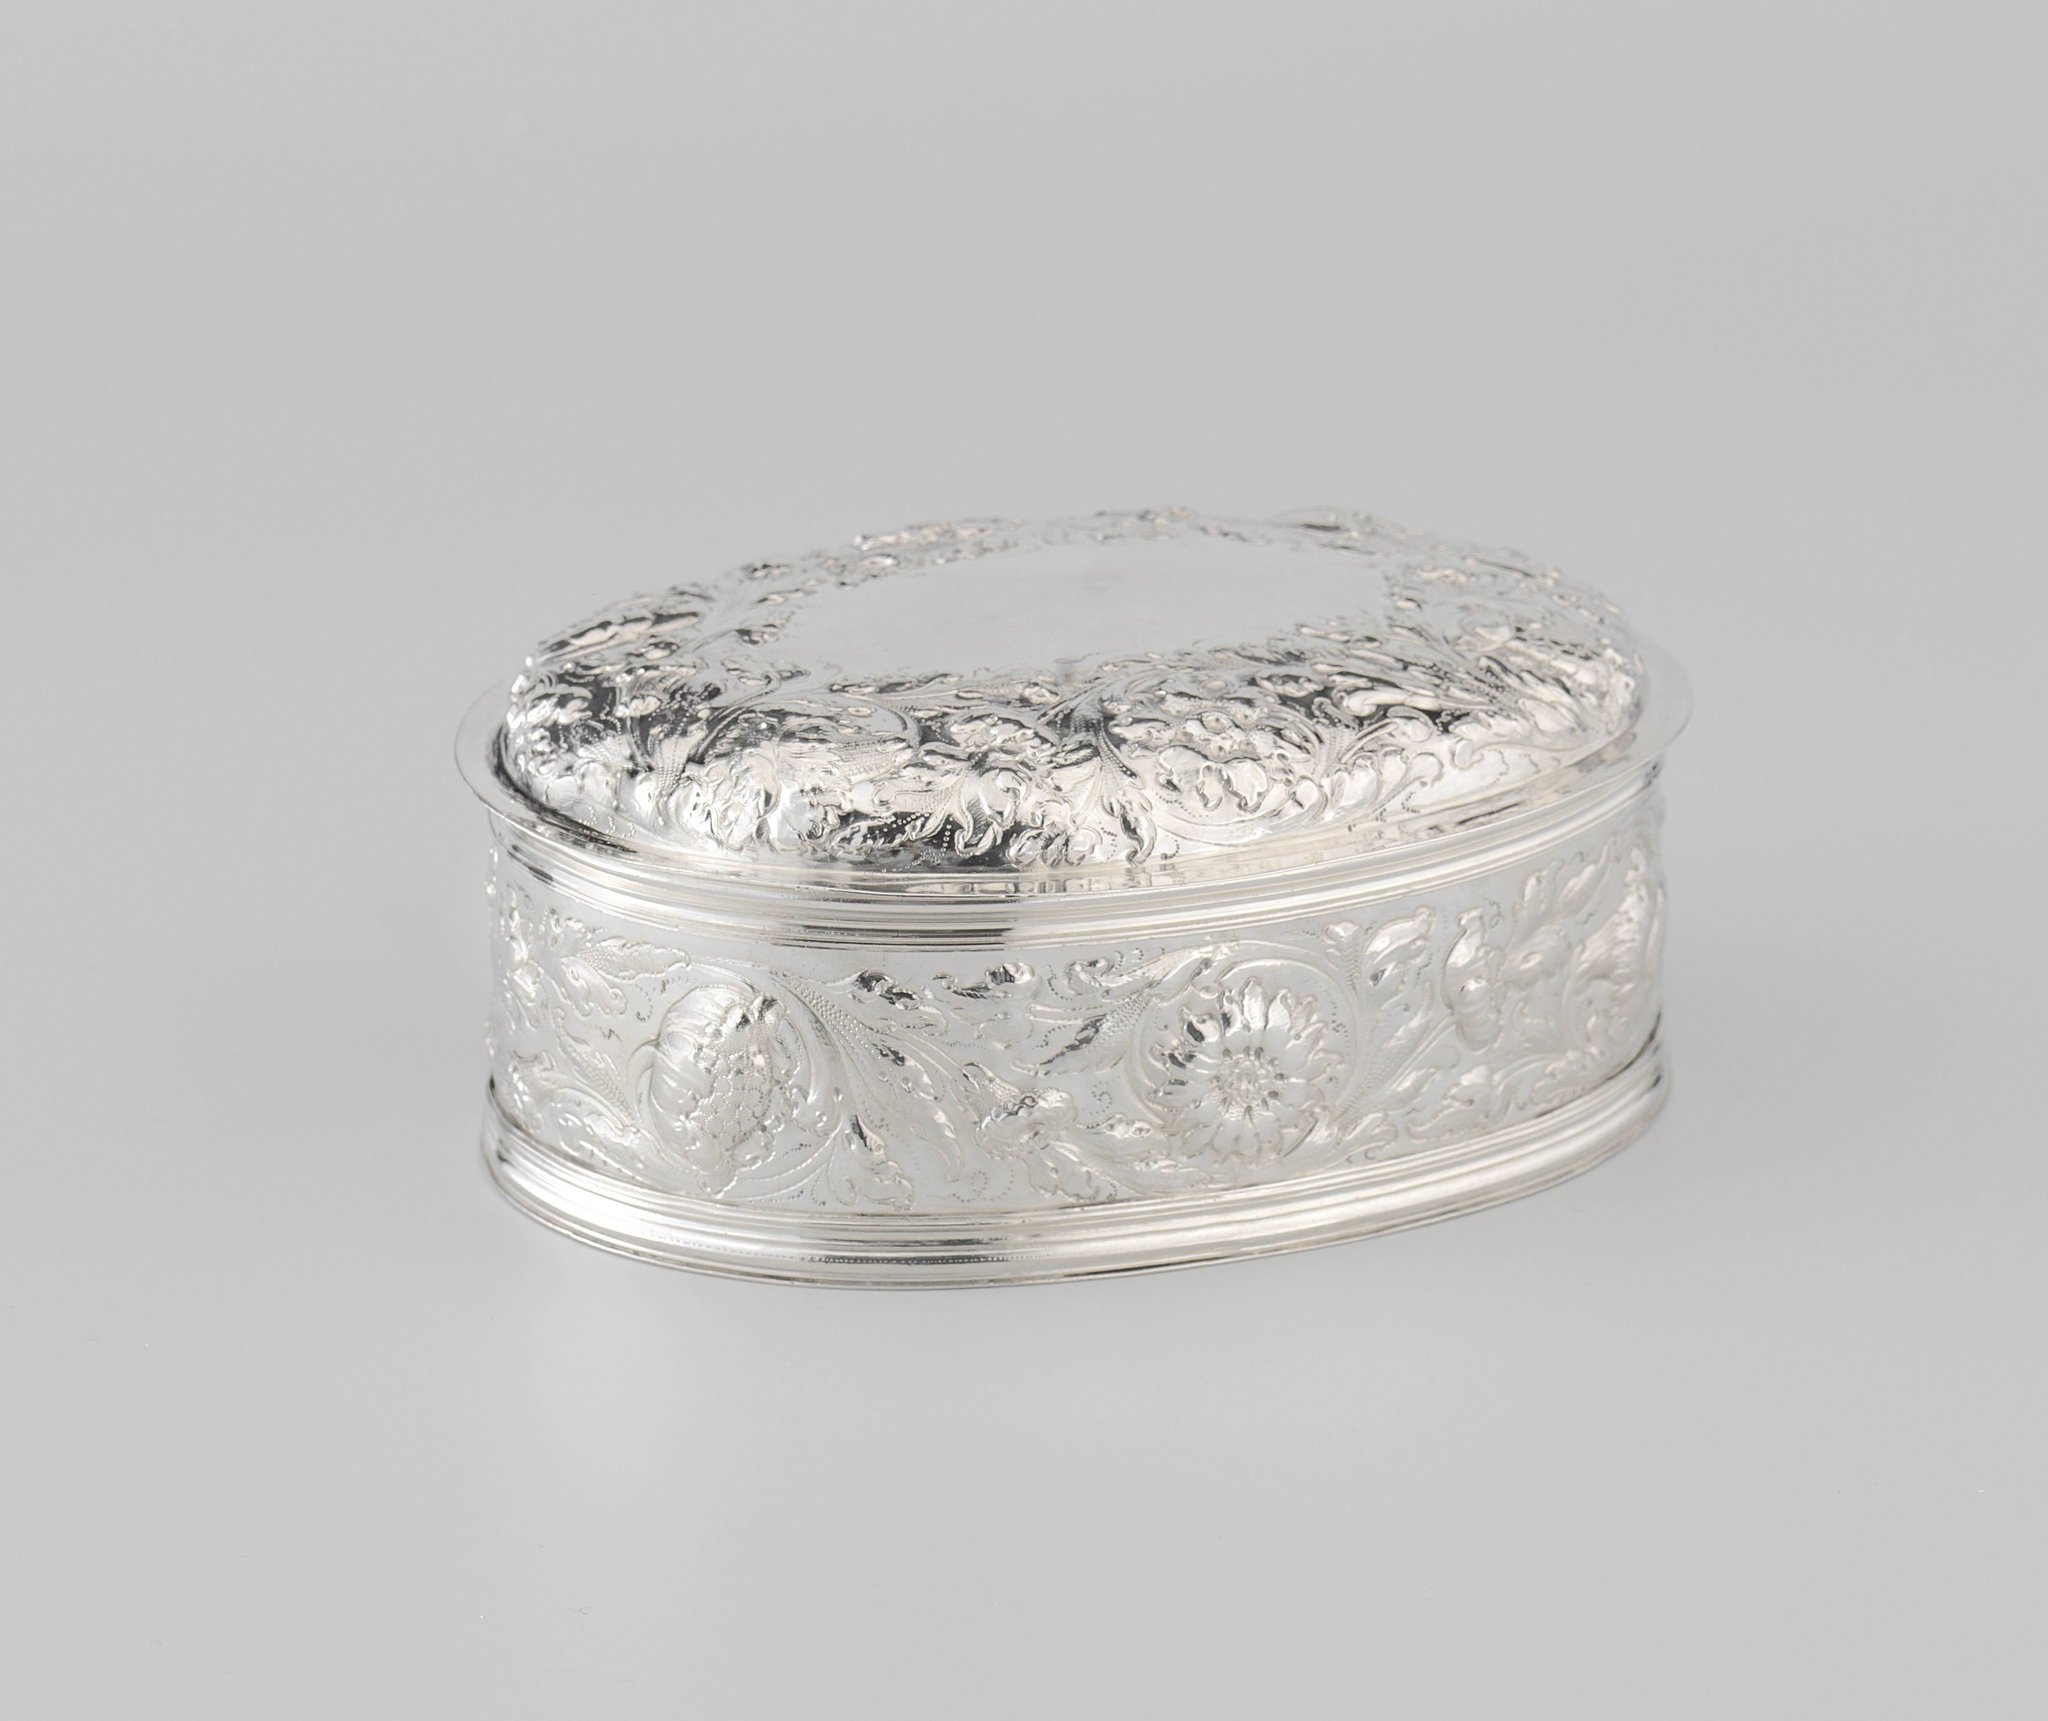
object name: box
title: Doos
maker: gerardus vinck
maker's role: silversmith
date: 1701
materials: silver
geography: rotterdam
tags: flowers ~ ornament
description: Box. Silver. Rotterdam, 1677, by Cornelis de Haan.